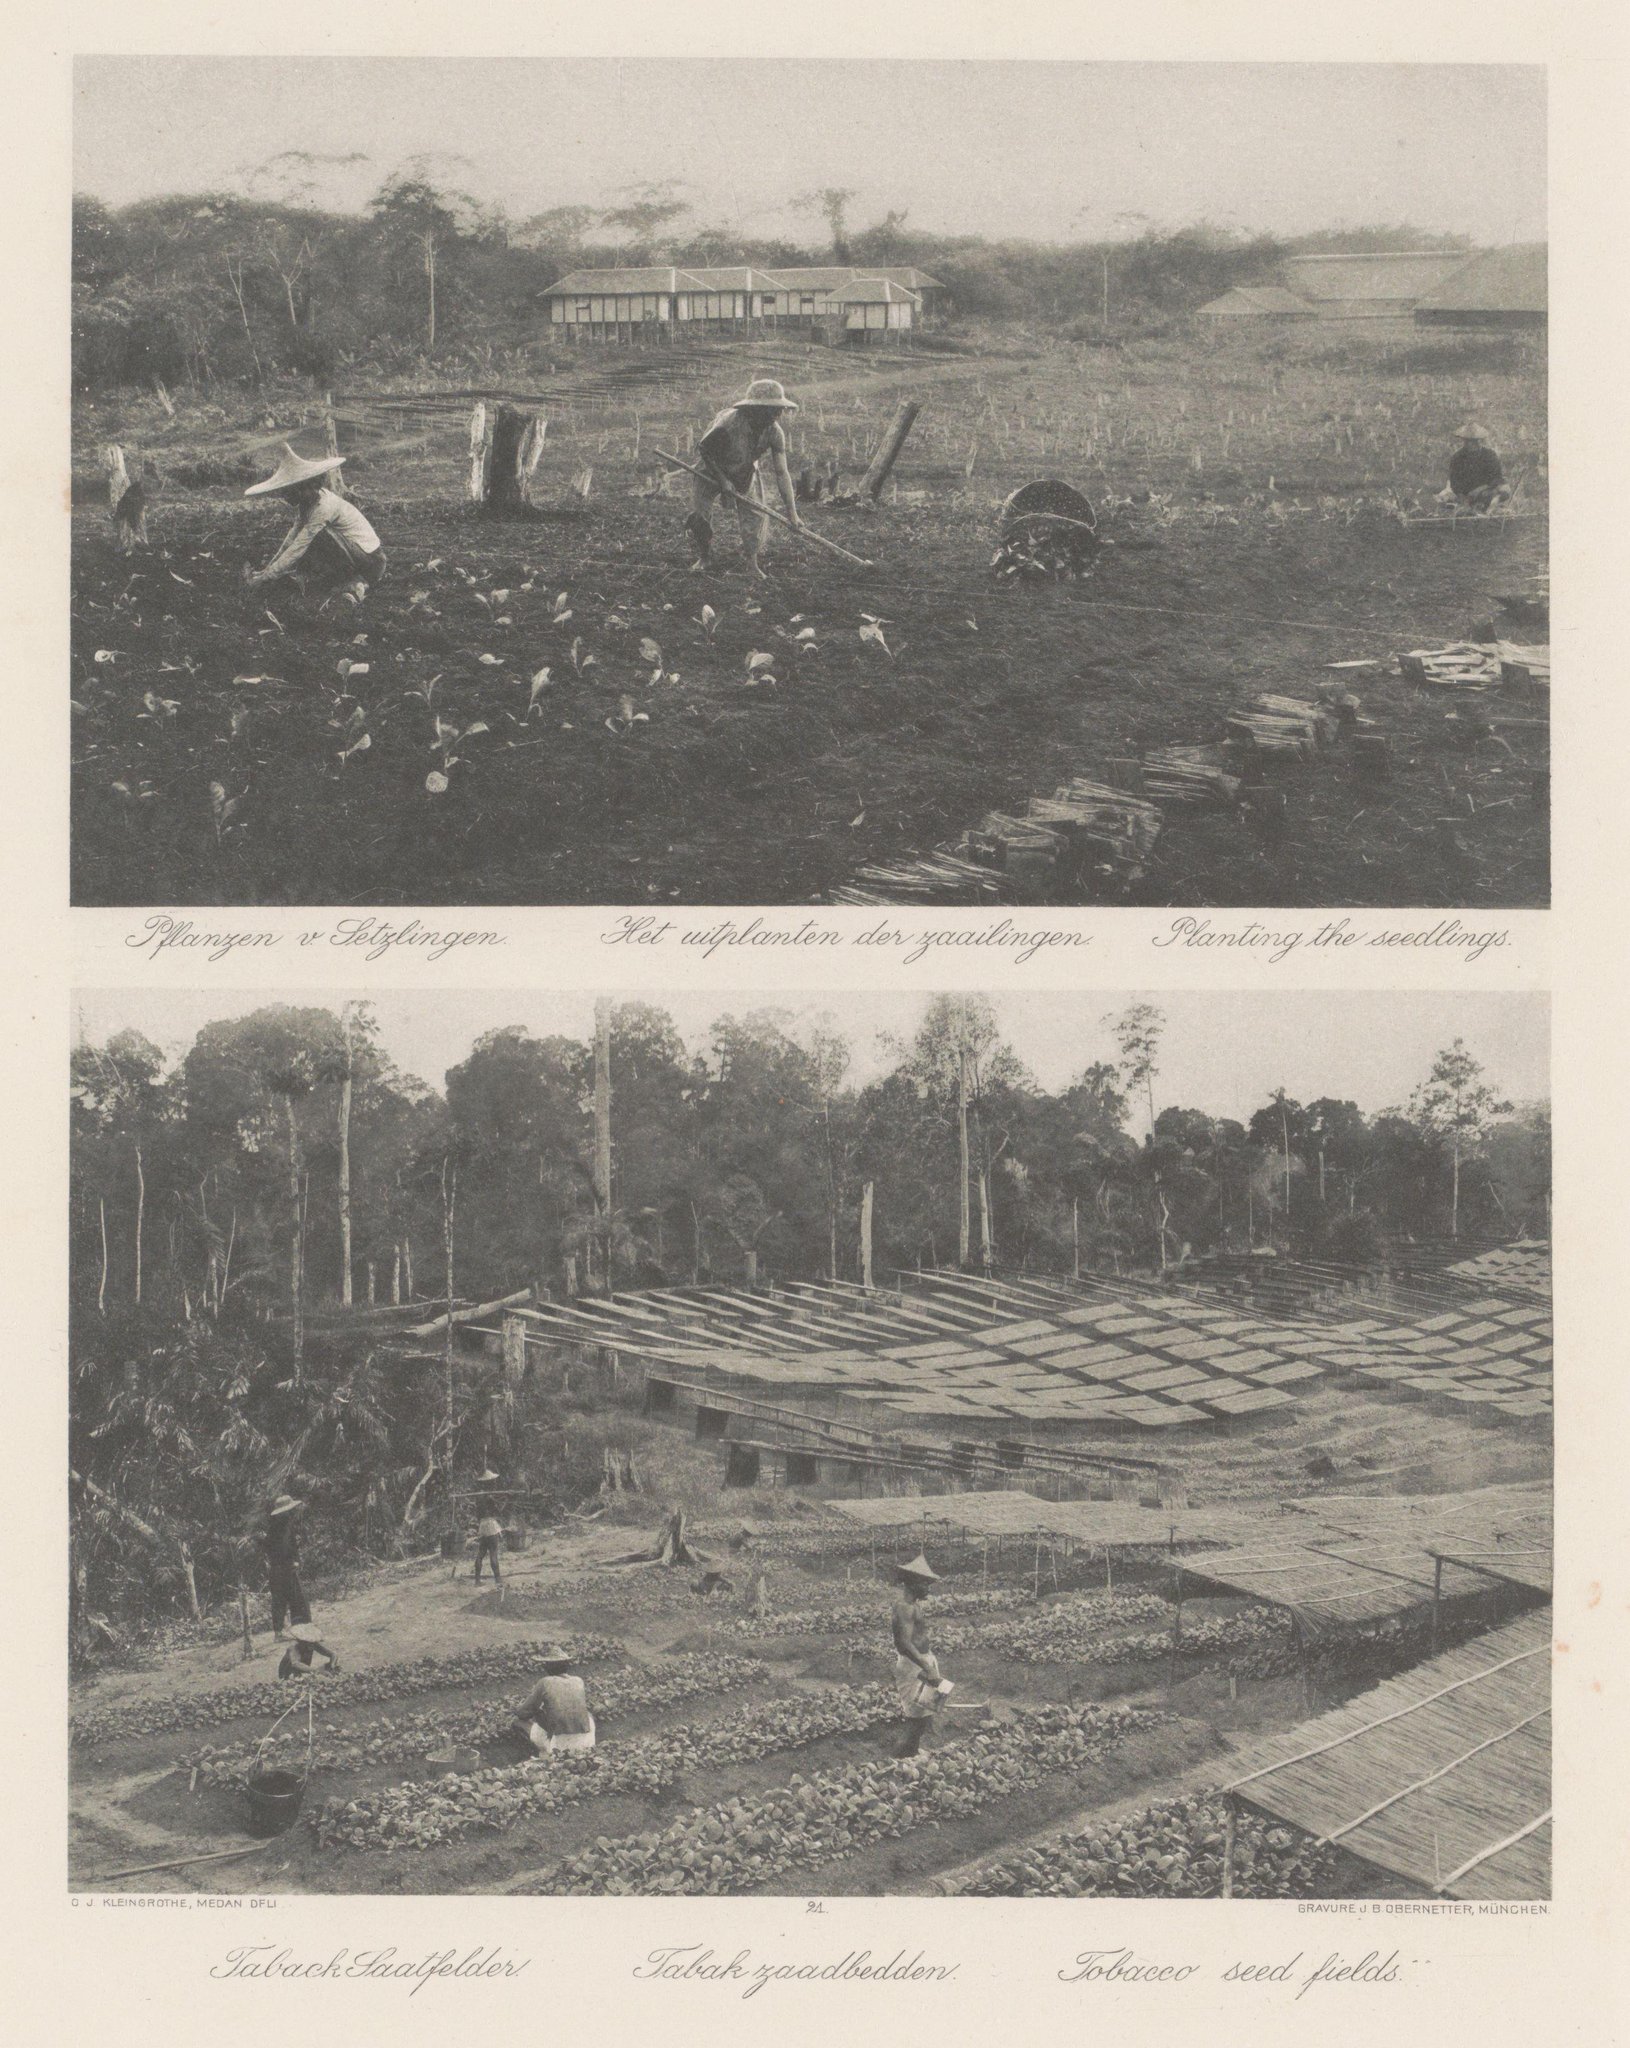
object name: photomechanical print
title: Het uitplanten van de zaailingen (boven), Tabakzaadbedden (onder)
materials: paper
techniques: photoaquatint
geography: munich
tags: plantation, tobacco, sumatra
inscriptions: number: ‘21’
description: Onderdeel van Album met heliogravures van Sumatra's oostkust.